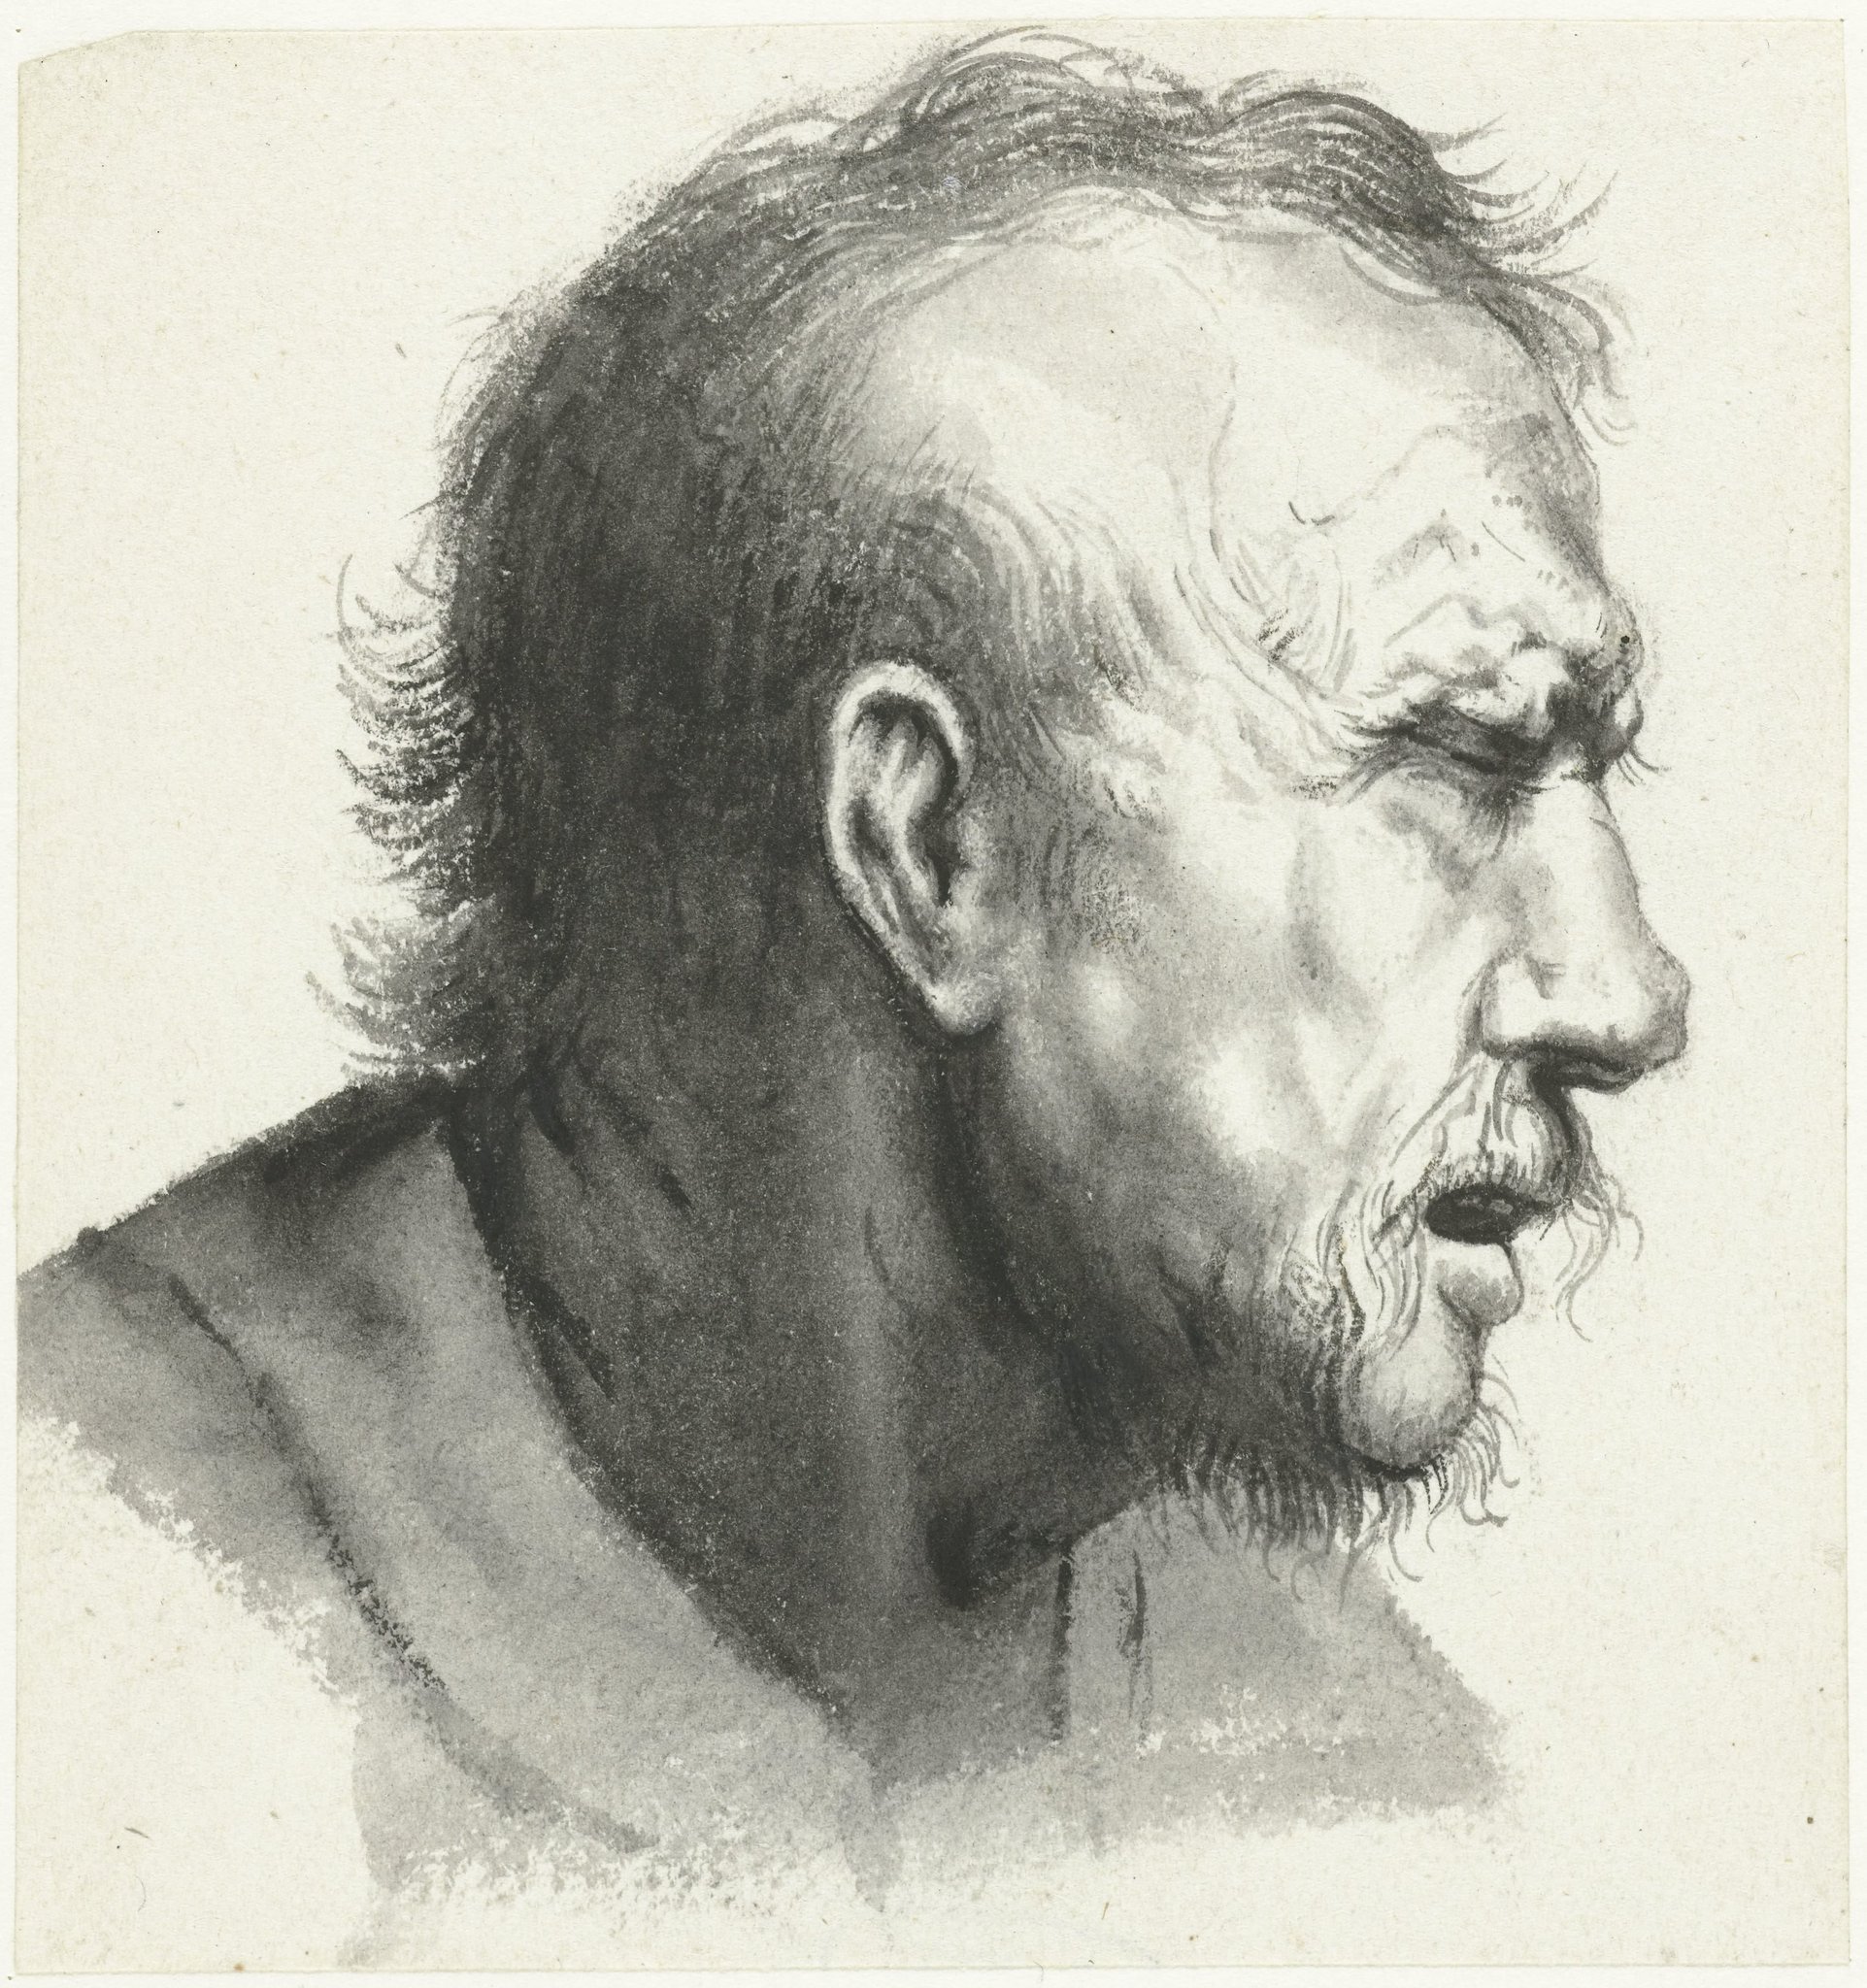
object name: drawing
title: Kop van de berouwvolle Judas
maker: moses ter borch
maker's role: draughtsman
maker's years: 1645-1667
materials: chalk, ink, paper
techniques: brush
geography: zwolle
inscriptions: annotation: ‘B22 ; Rembr./v.Vliet’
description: Kopie naar prent van J.[G.?] van Vliet uit 1634 (B. 22), naar Rembrandt.